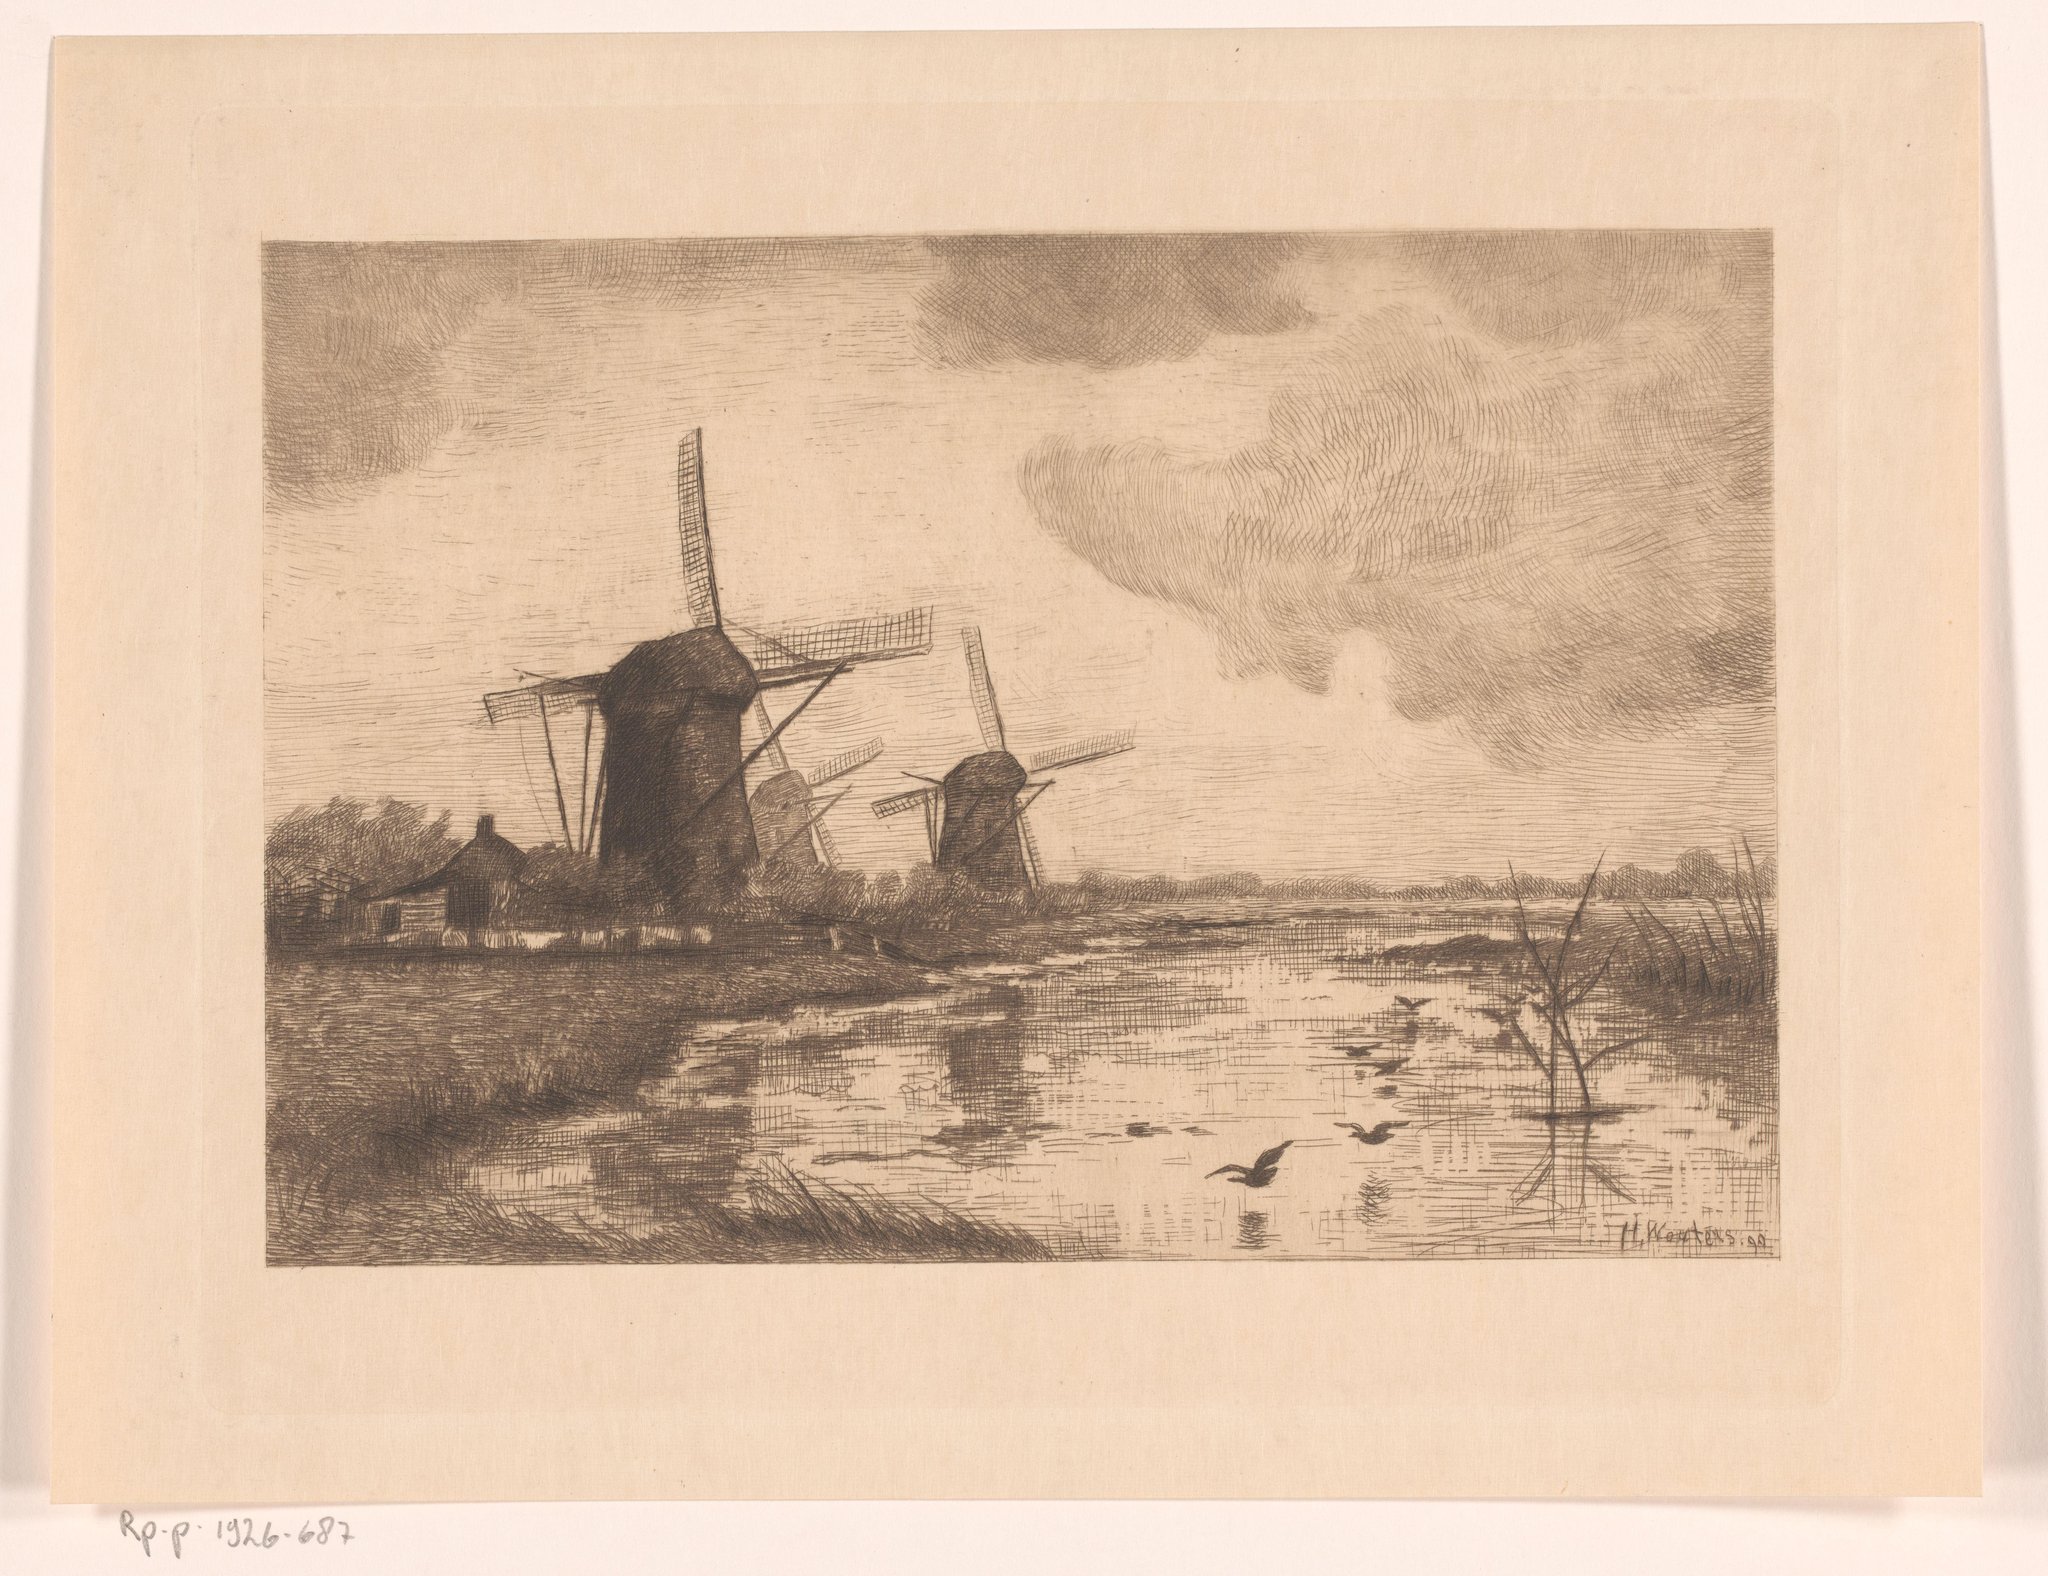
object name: print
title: Drie molens in een waterlandschap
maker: henri wouters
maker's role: draughtsman, print maker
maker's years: 1866-1935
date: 1890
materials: paper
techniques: drypoint, etching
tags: swamps and polders, windmill in landscape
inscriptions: collector's mark: Lugt 2166